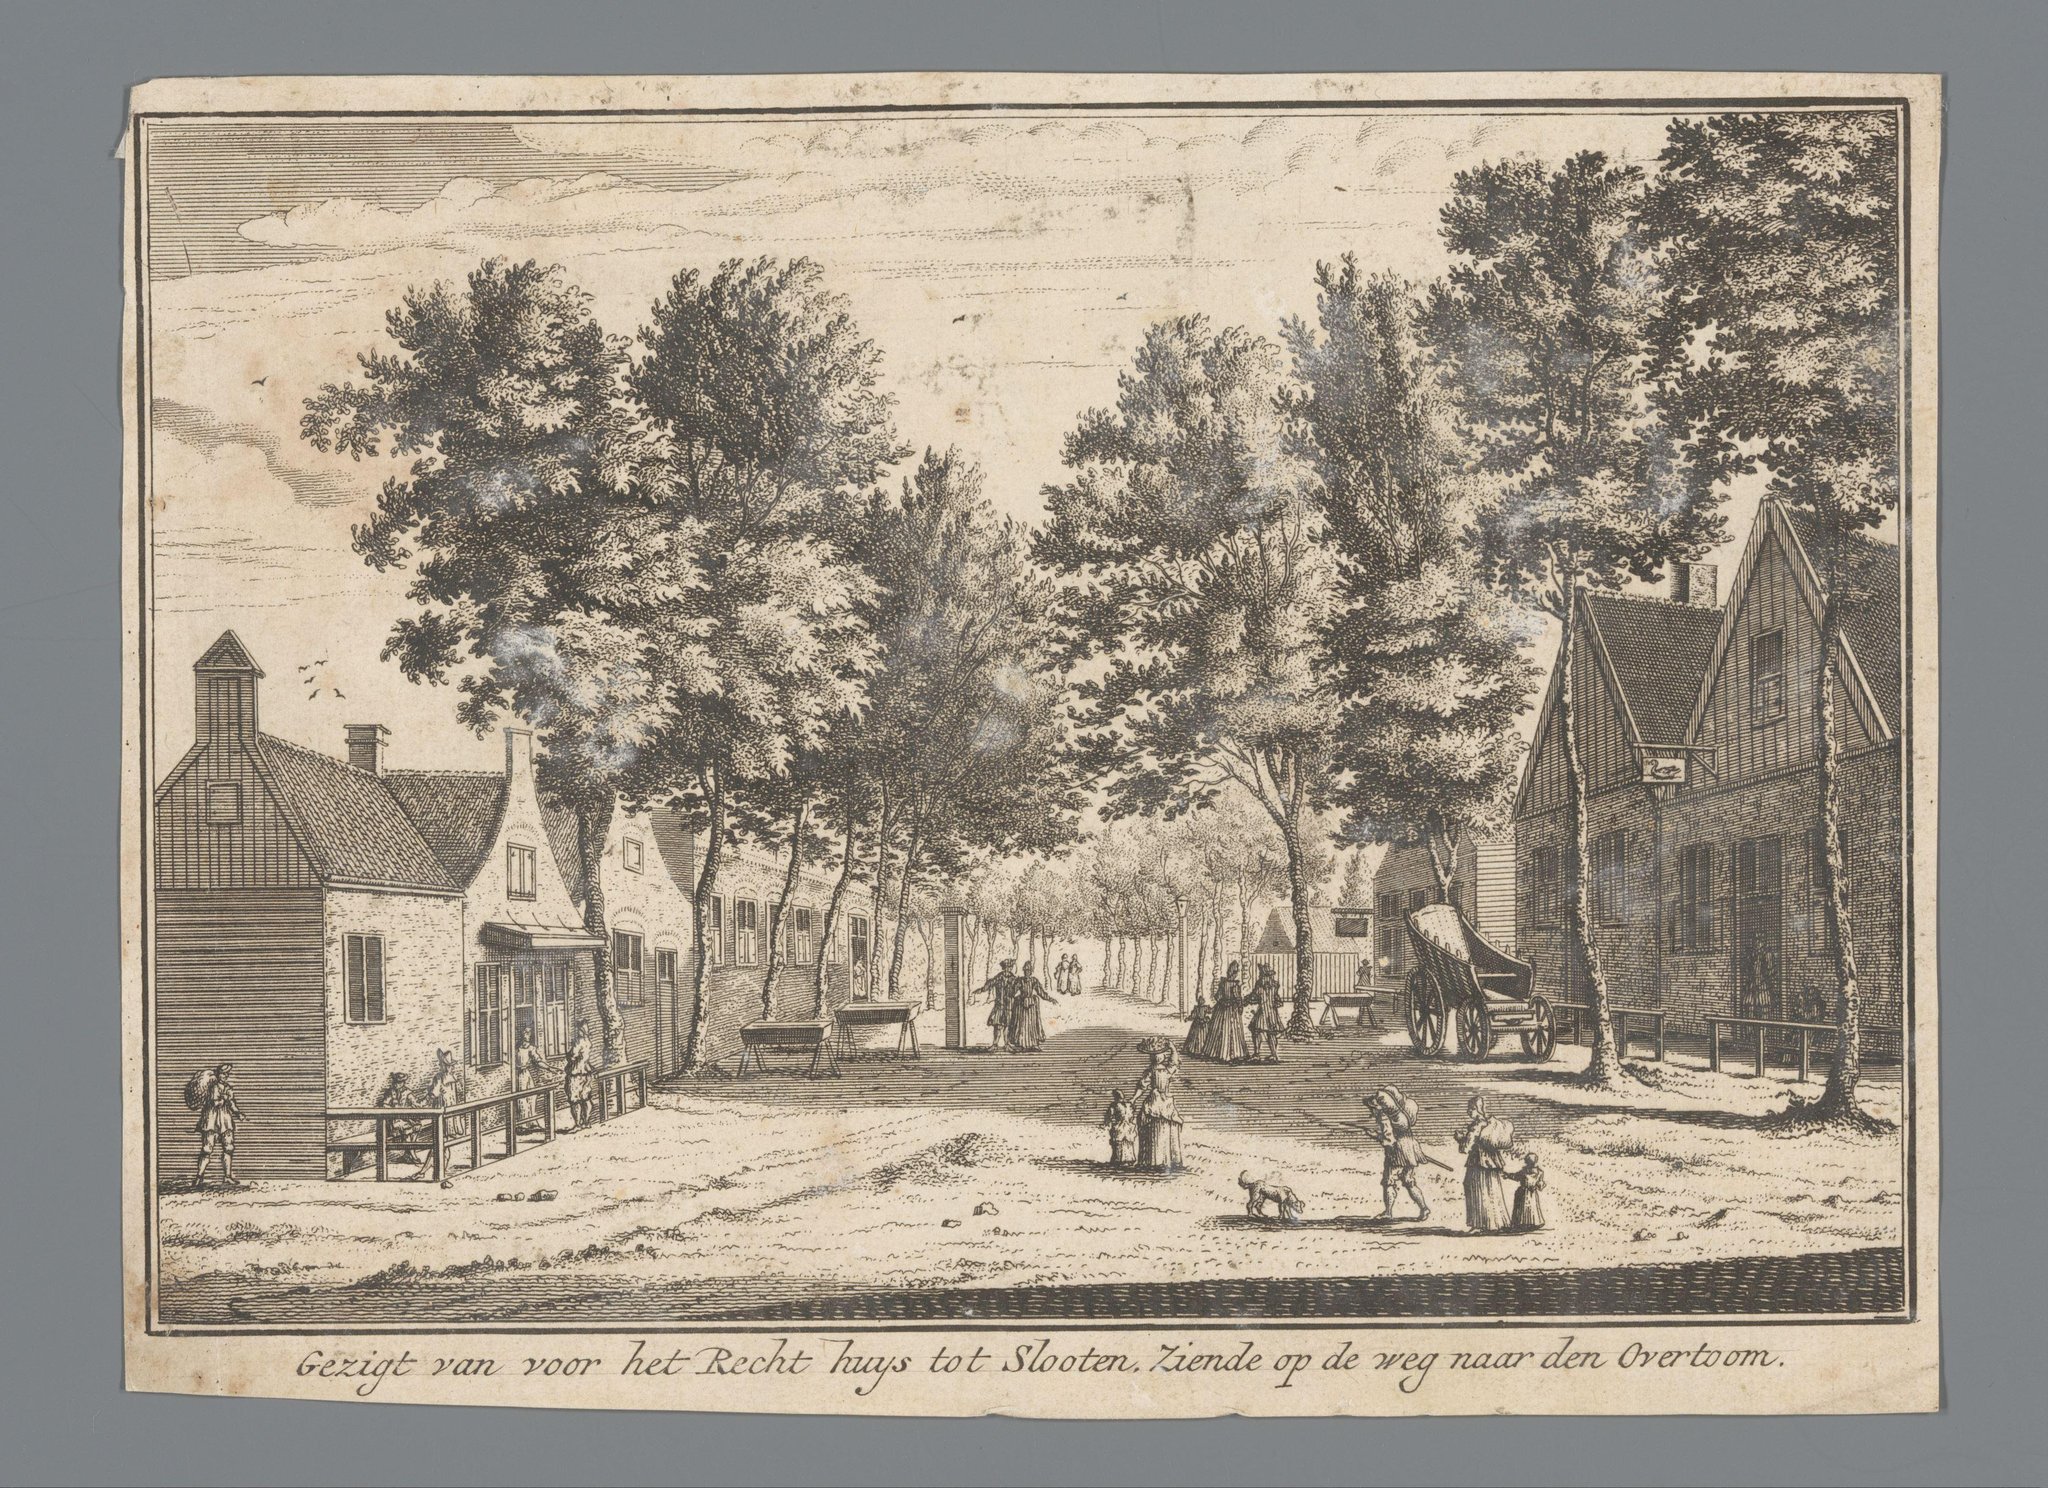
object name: print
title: Gezigt van voor het Recht huys tot Slooten, Ziende op de weg naar den Overtoom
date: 1730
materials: paper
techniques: etching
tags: village street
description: Prent mogelijk verschenen in: Spiegel van Amsterdams zomervreugd, op de dorpen Amstelveen, Slooten, en den Overtoom (...). Amsterdam: Leonardus Schenk, [1730].